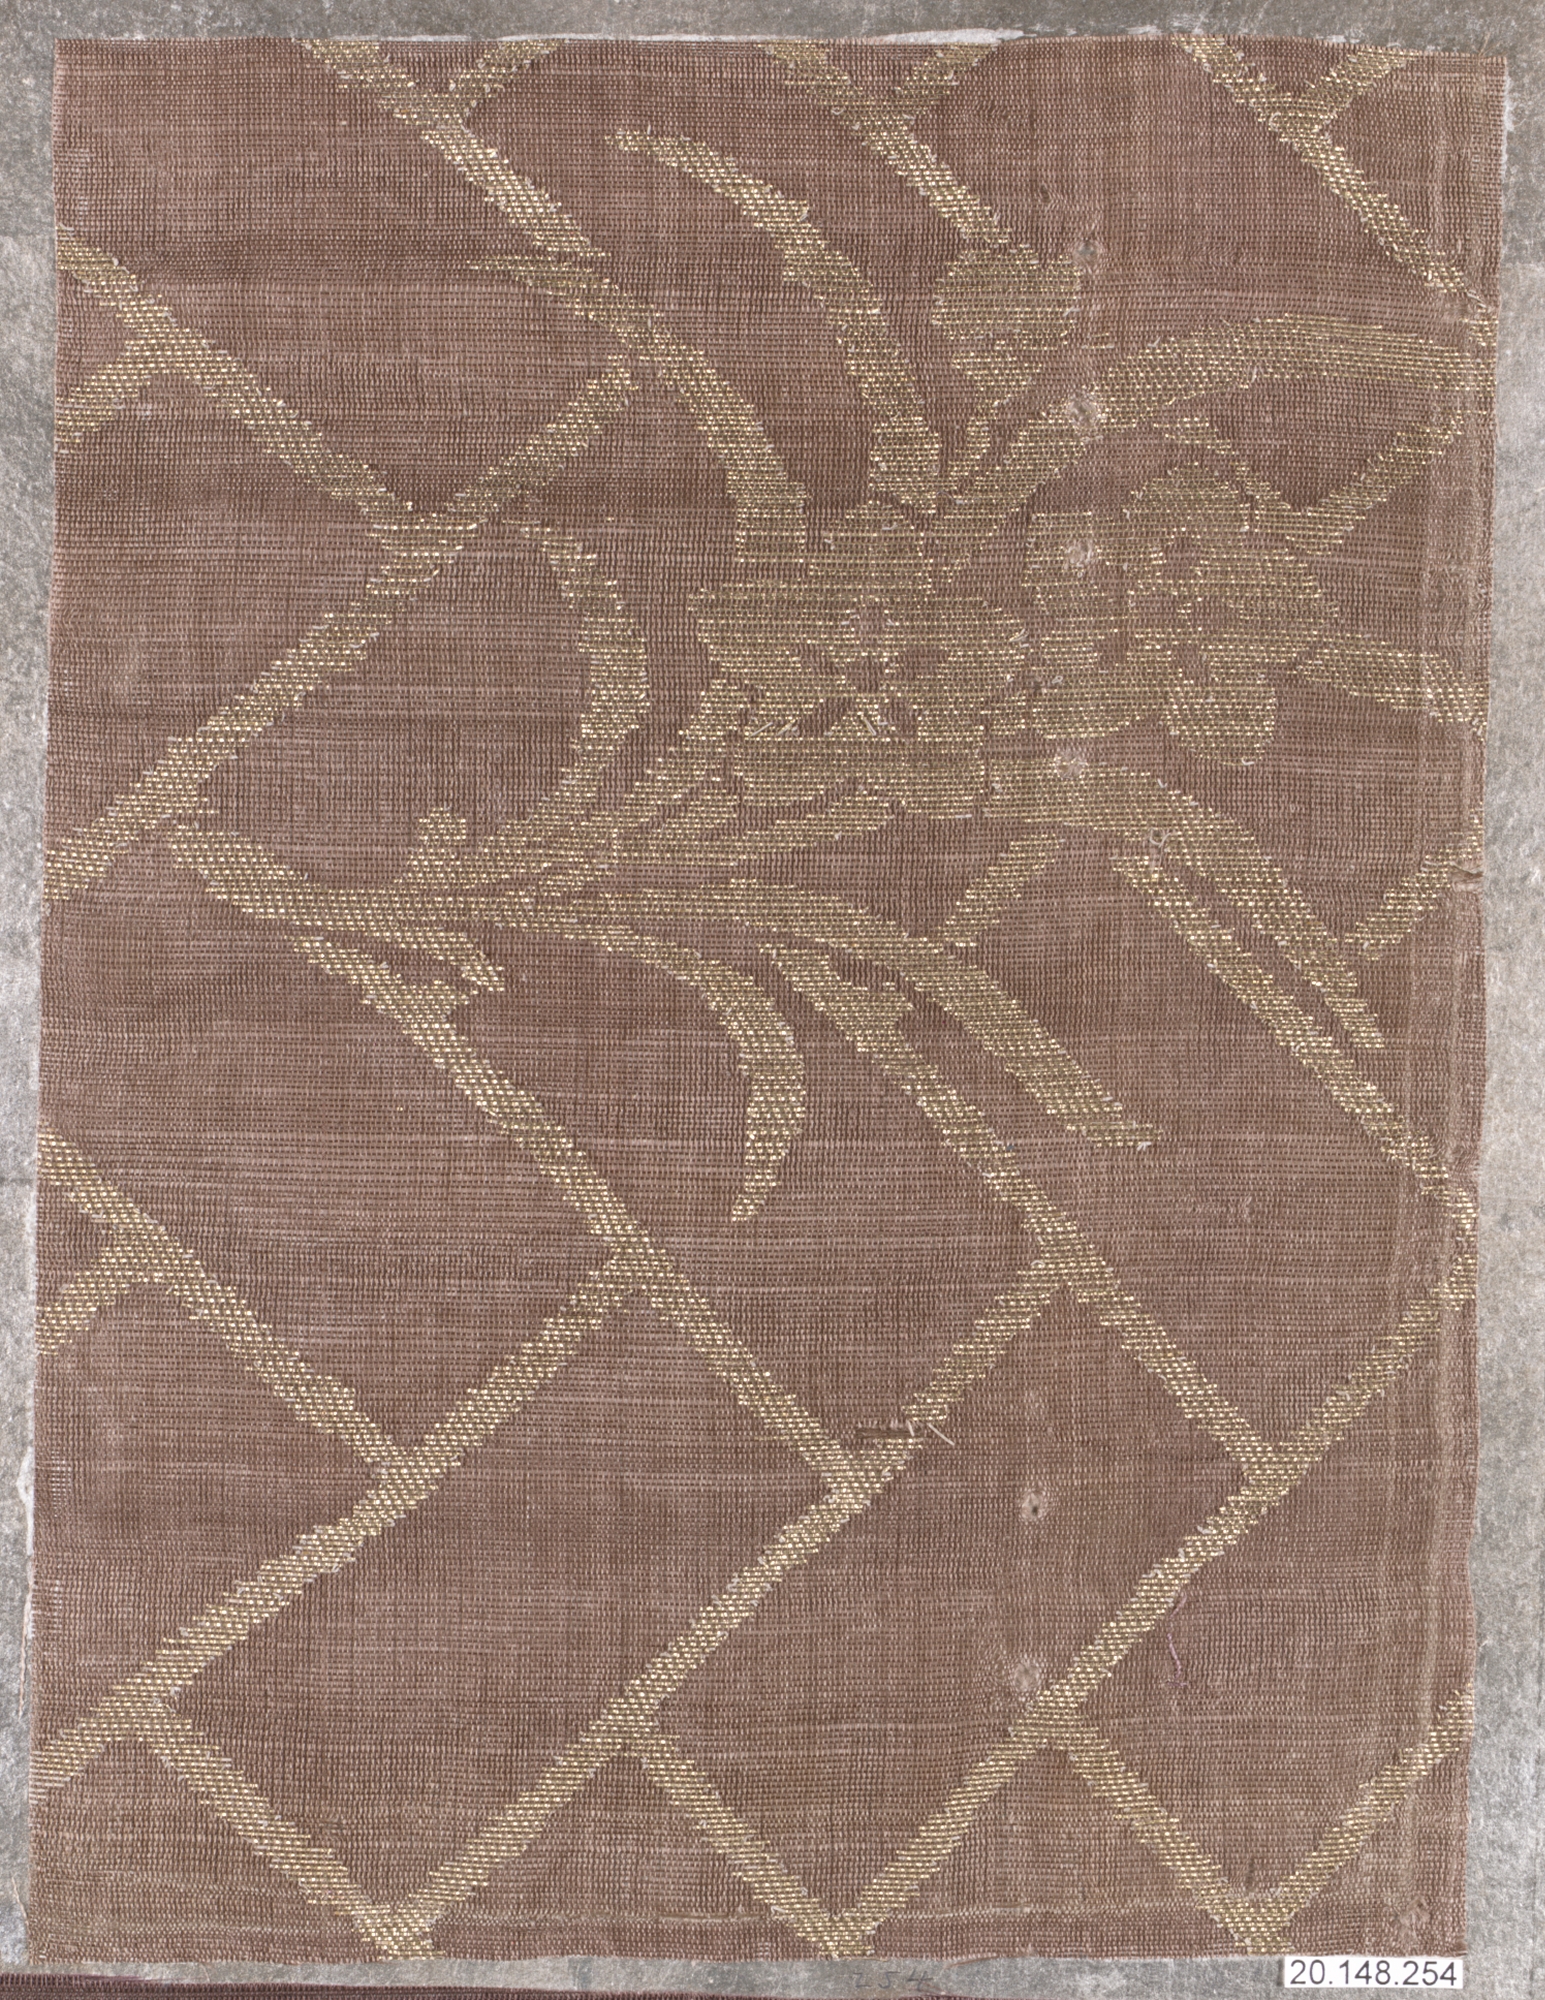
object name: piece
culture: japanese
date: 1701-1800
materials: silk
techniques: compound weave